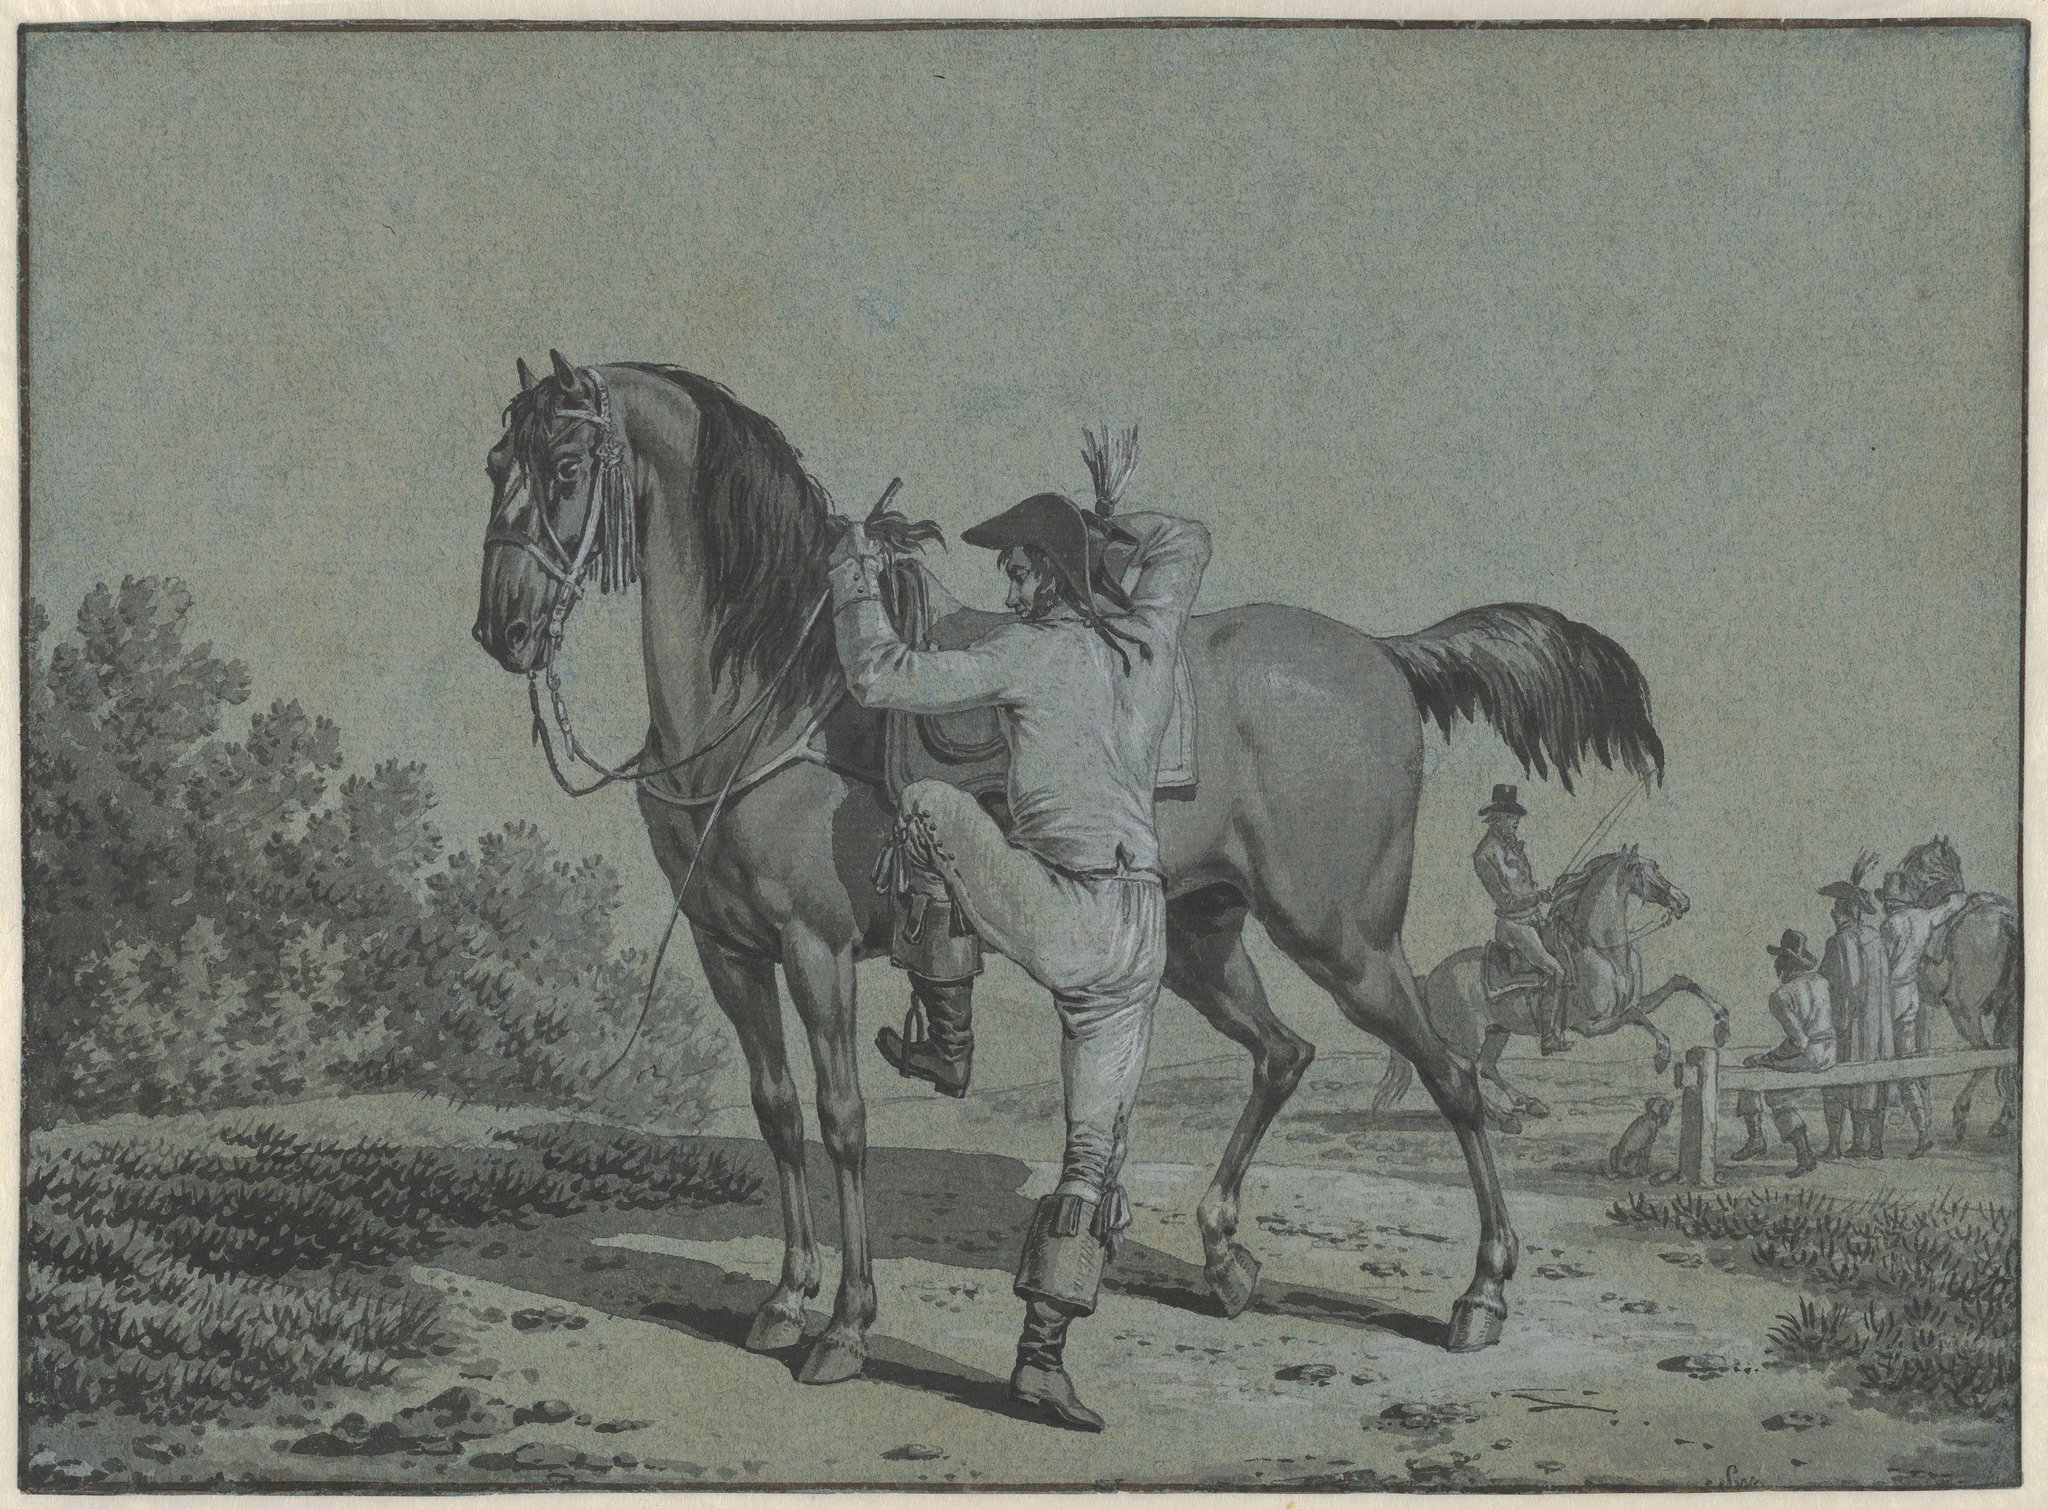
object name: drawing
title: Man Mounting a Horse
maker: jacques françois joseph swebach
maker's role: artist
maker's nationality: french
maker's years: 1769-1823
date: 1783-1823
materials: gouache, ink, paper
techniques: brush, heightening, pen, wash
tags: men,horses